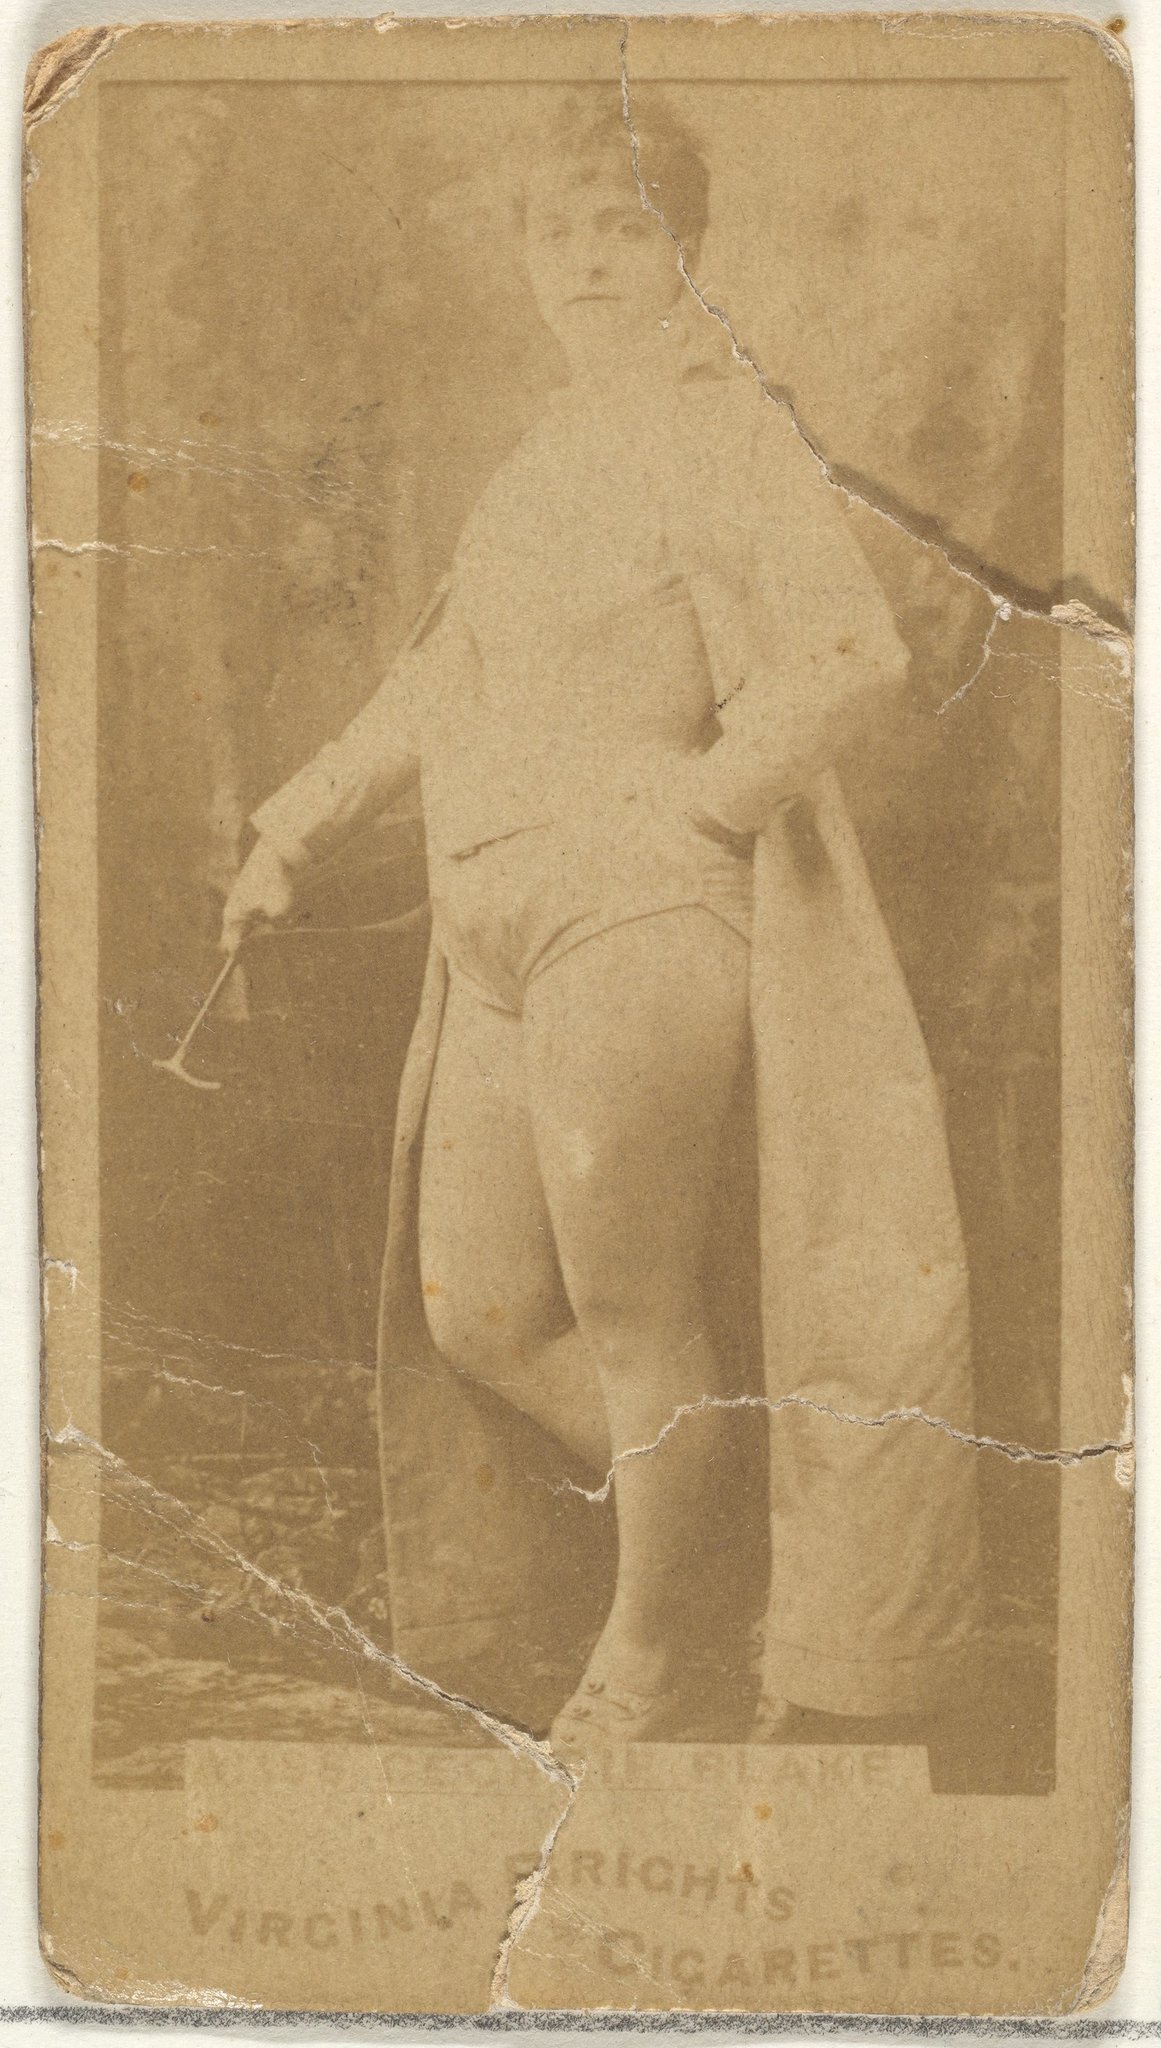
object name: photograph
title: Miss Georgie Blake, from the Actors and Actresses series (N45, Type 1) for Virginia Brights Cigarettes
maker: allen & ginter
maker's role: publisher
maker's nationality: american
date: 1888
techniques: albumen silver print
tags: portraits,women,actresses